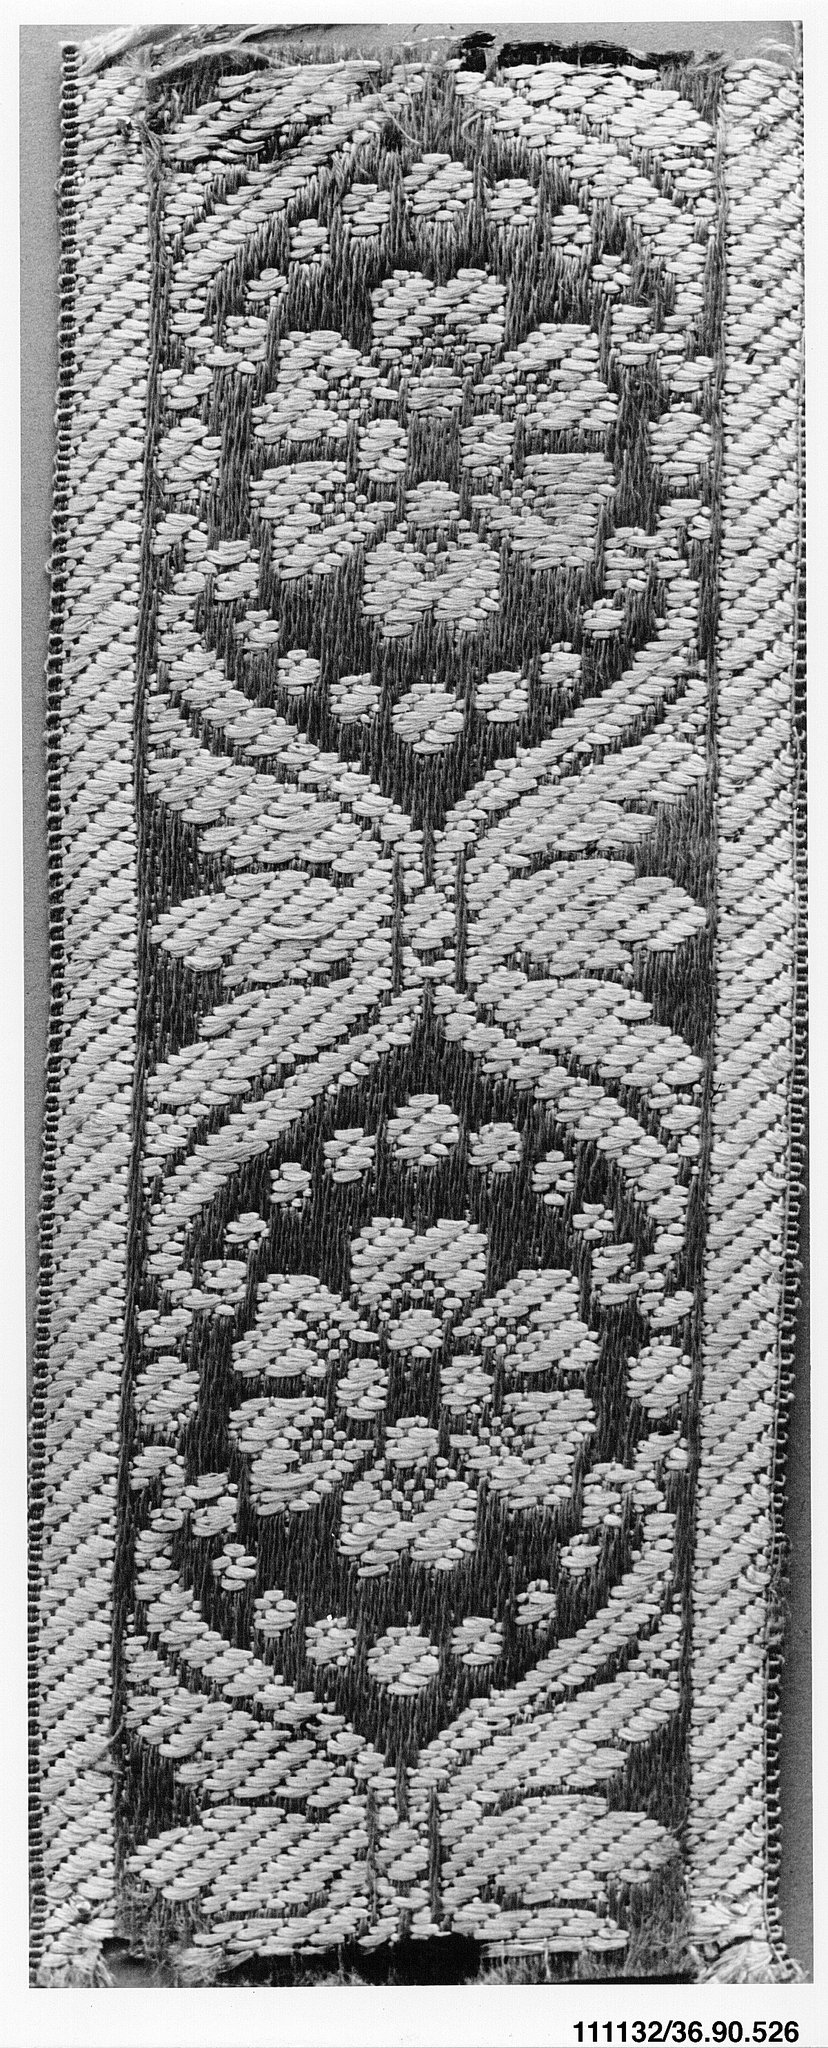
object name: piece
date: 1801-1833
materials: silk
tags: flowers